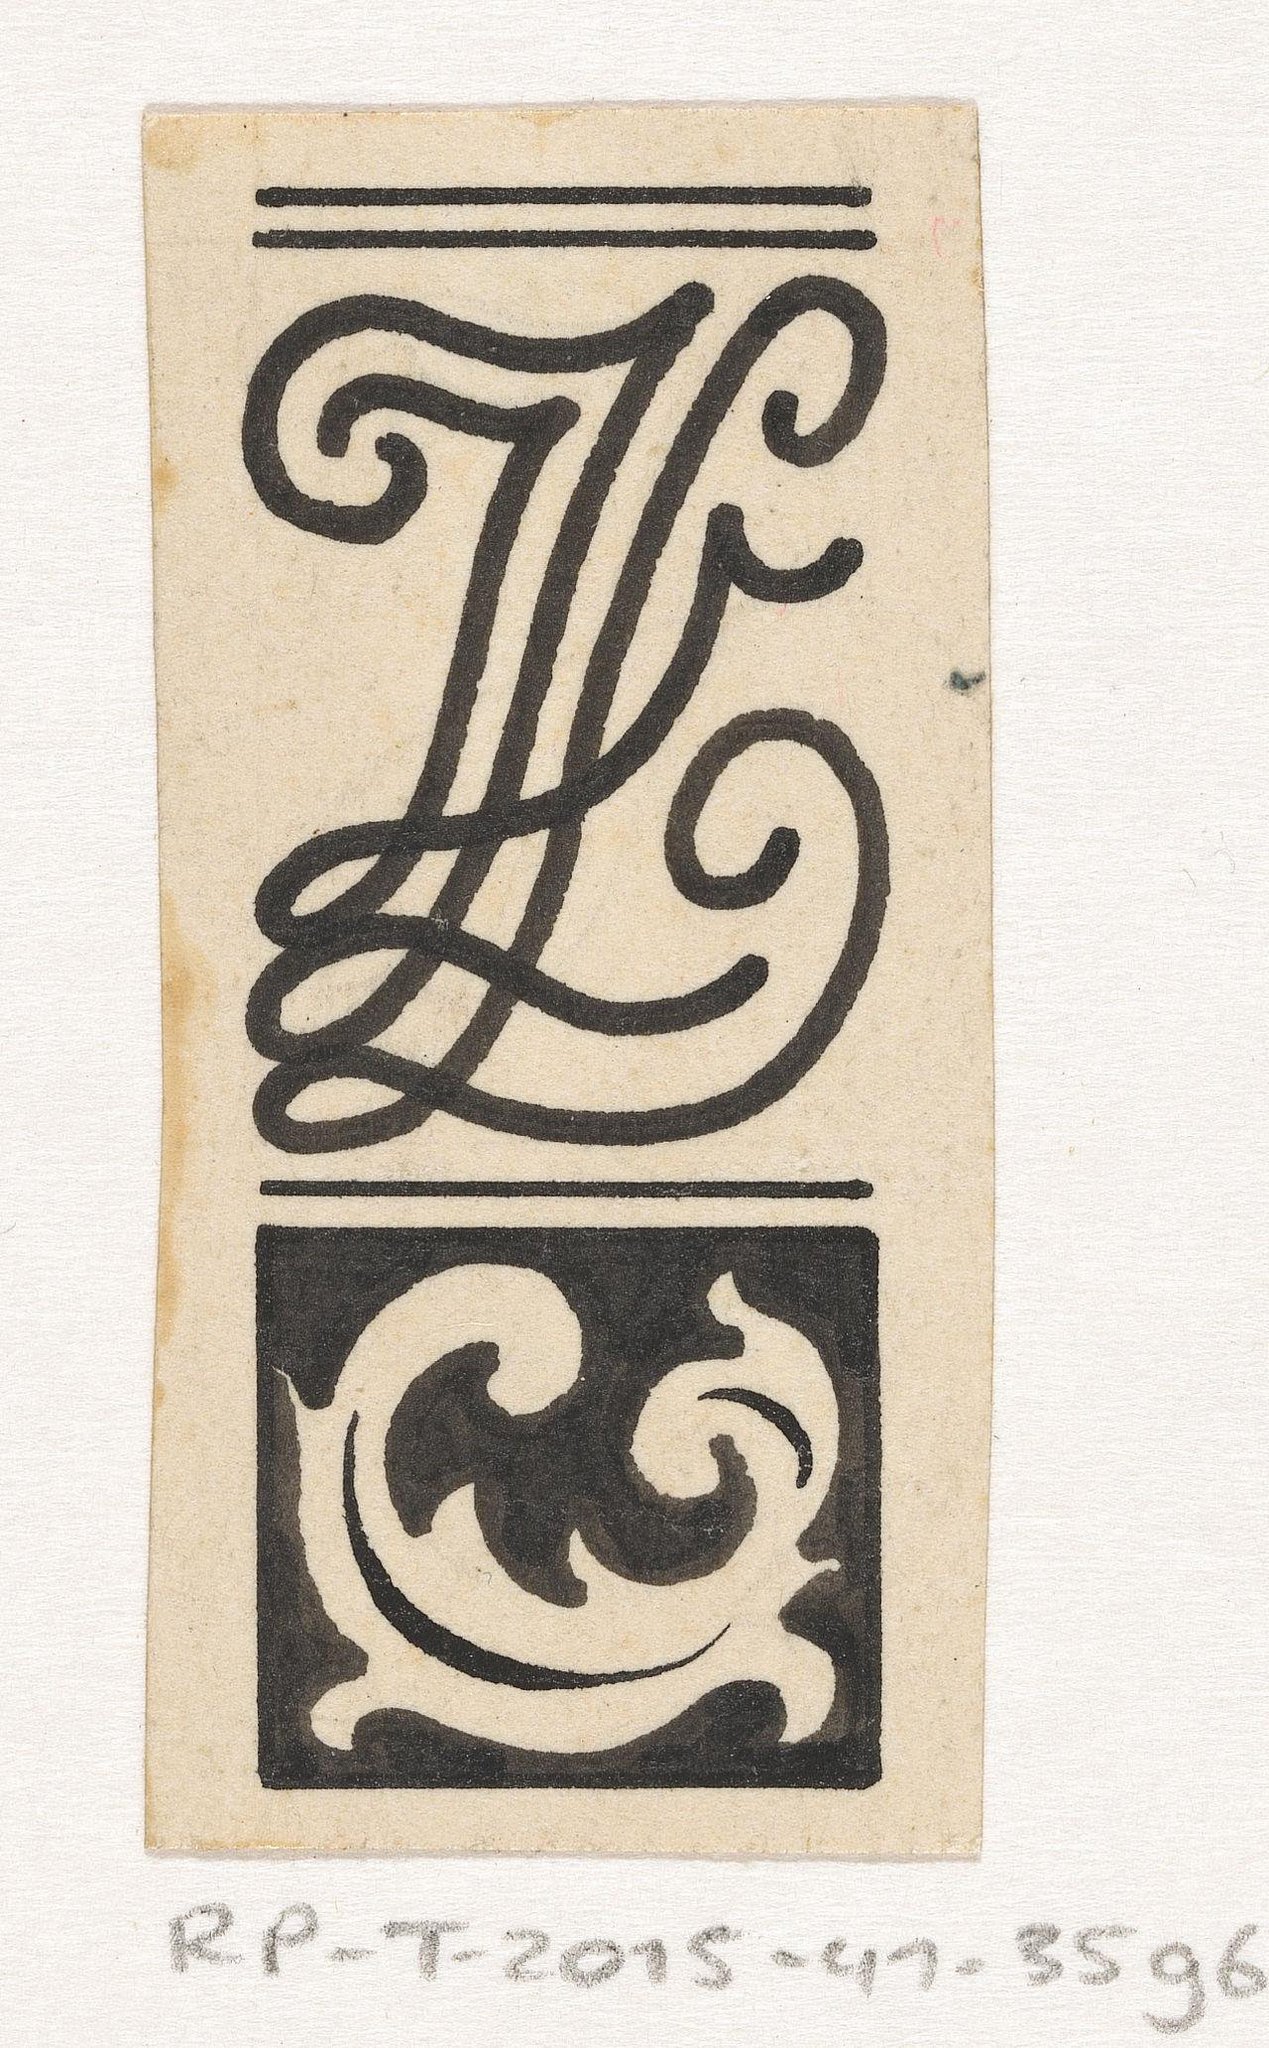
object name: boekillustratie ontwerp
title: Vignet van Uitgeversmaatschappij L.J. Veen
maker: Anonymous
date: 1890-1930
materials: ink, paper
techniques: brush, pen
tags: rocaille ornament, magic mathematical figures; magic numbers, words, monograms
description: Monogram met de letters L, J en V gevat tussen twee parallel lopende horizontale lijnen en een rocaille.